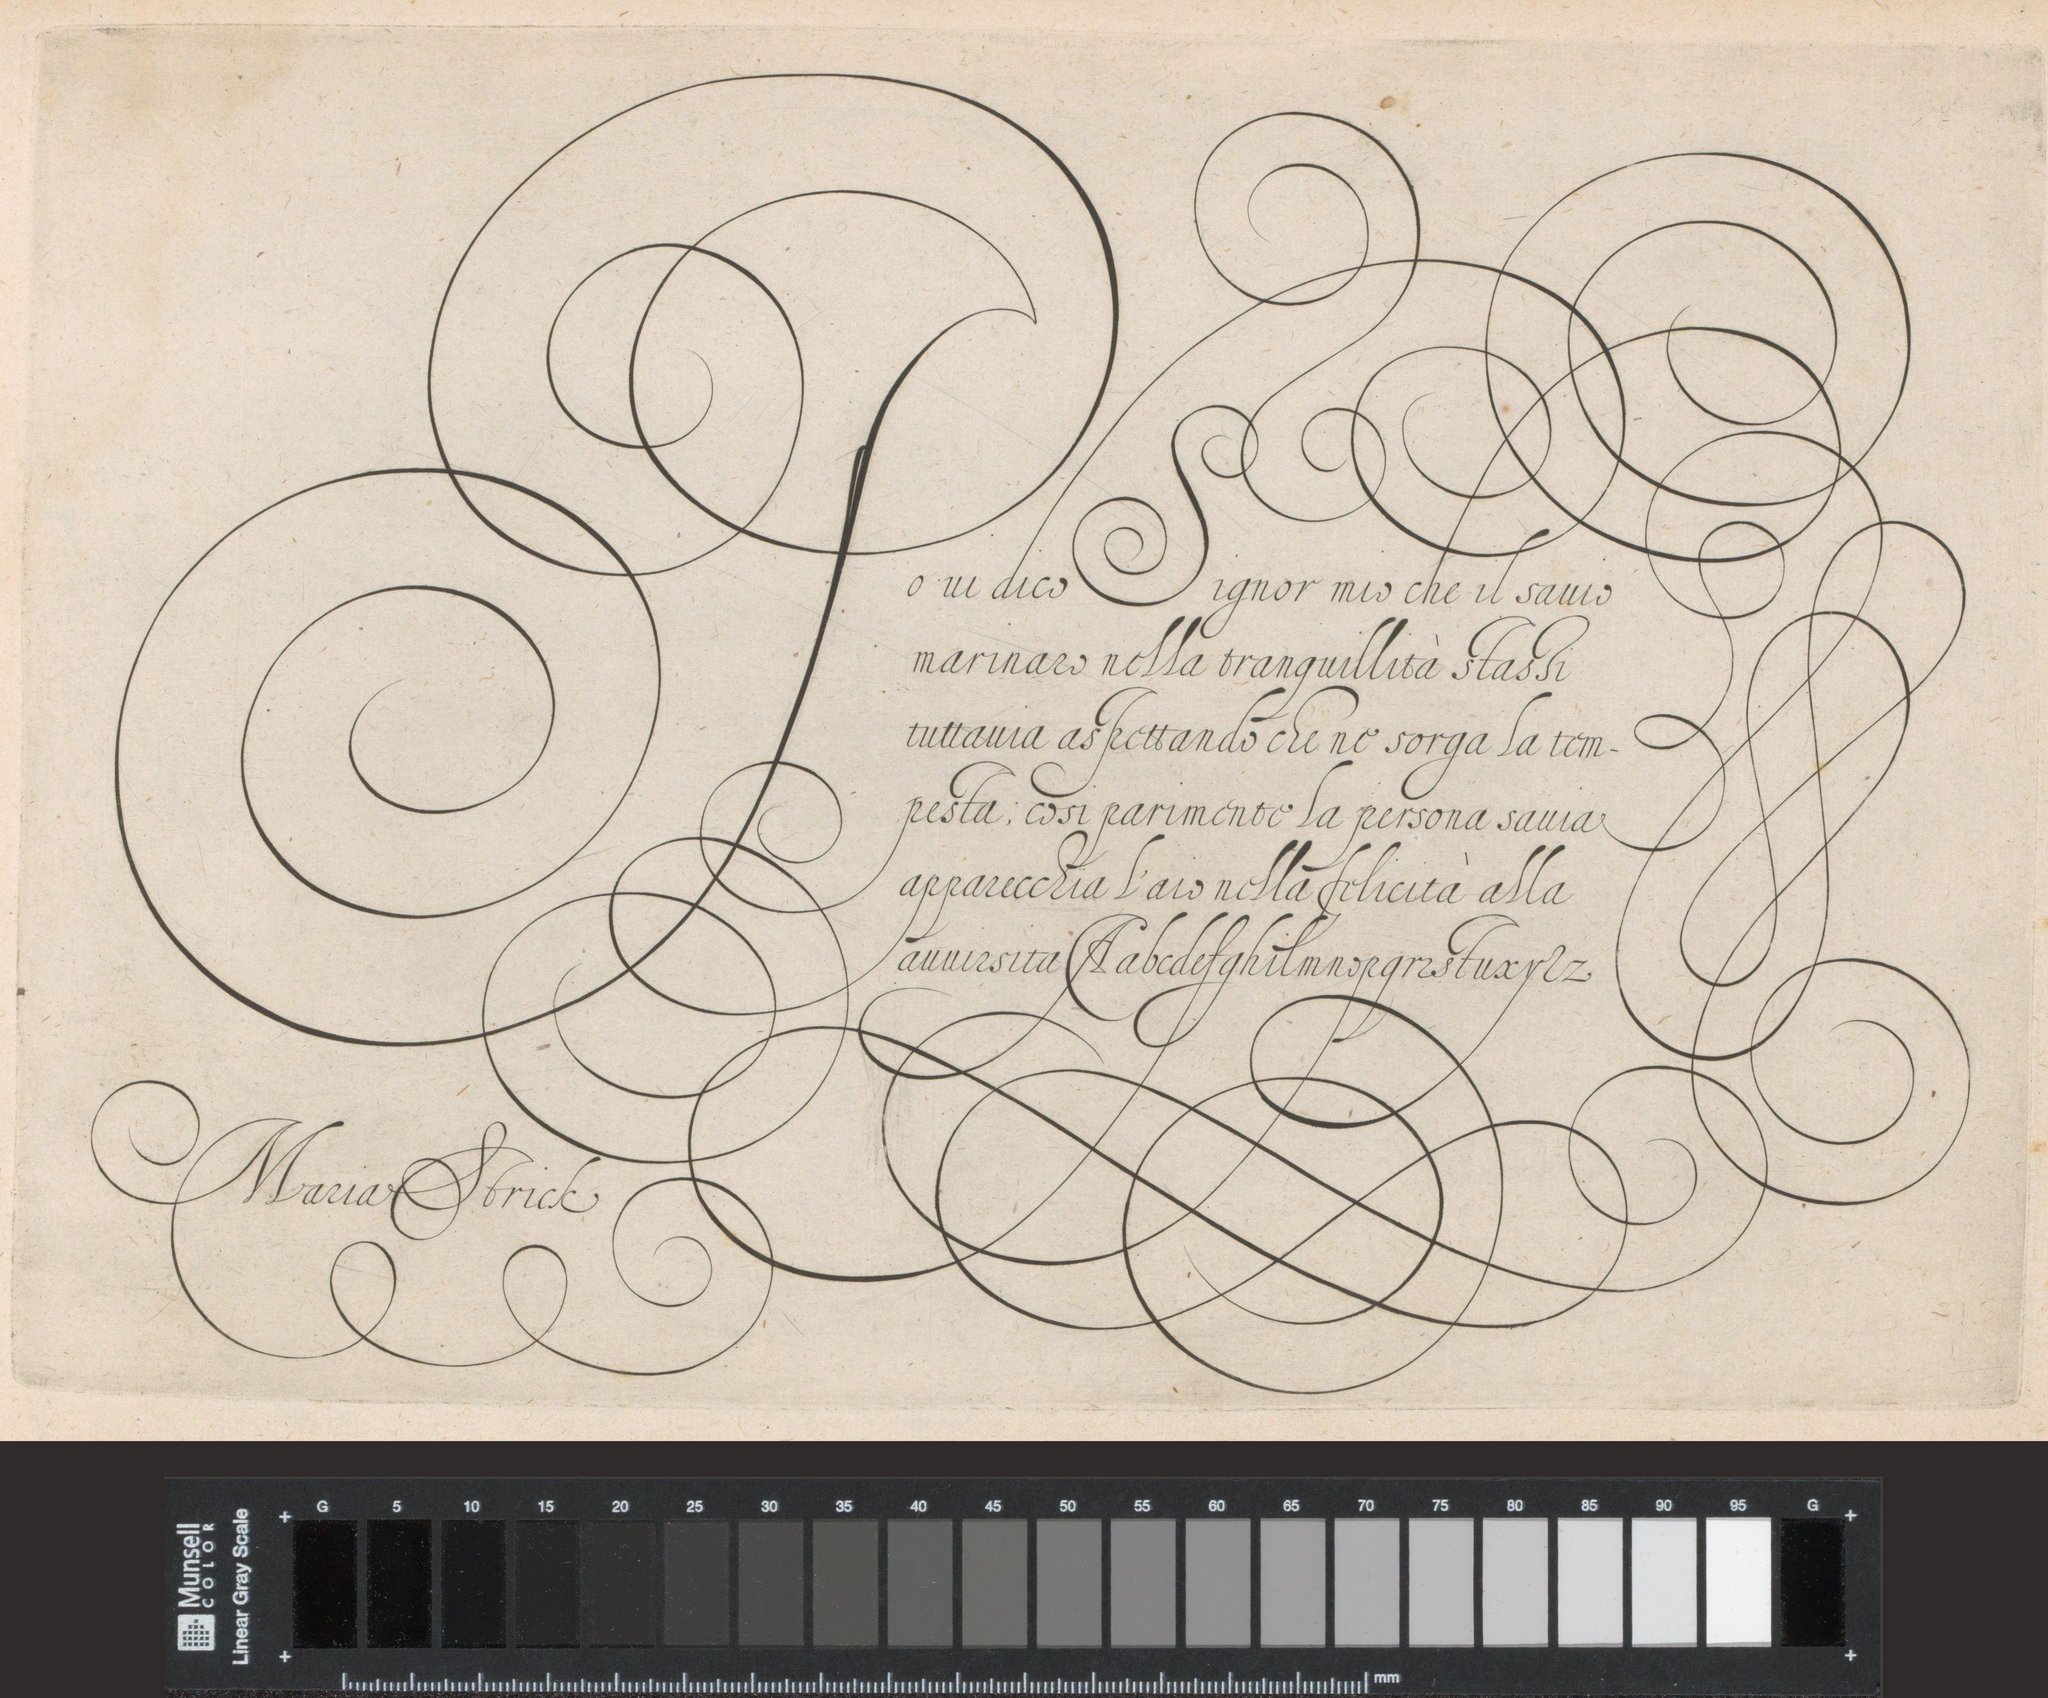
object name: album leaf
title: Schat oft voorbeelt ende verthooninge van verscheyden geschriften (...)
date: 1618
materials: paper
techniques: engraving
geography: rotterdam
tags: calligraphy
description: Schrijfvoorbeeld in het Italiaans met kapitaal J en zes regels tekst: Joui dico Signor mio che il savio (...). Omlijst door kalligrafisch krulwerk. De prent maakt deel uit van een album.